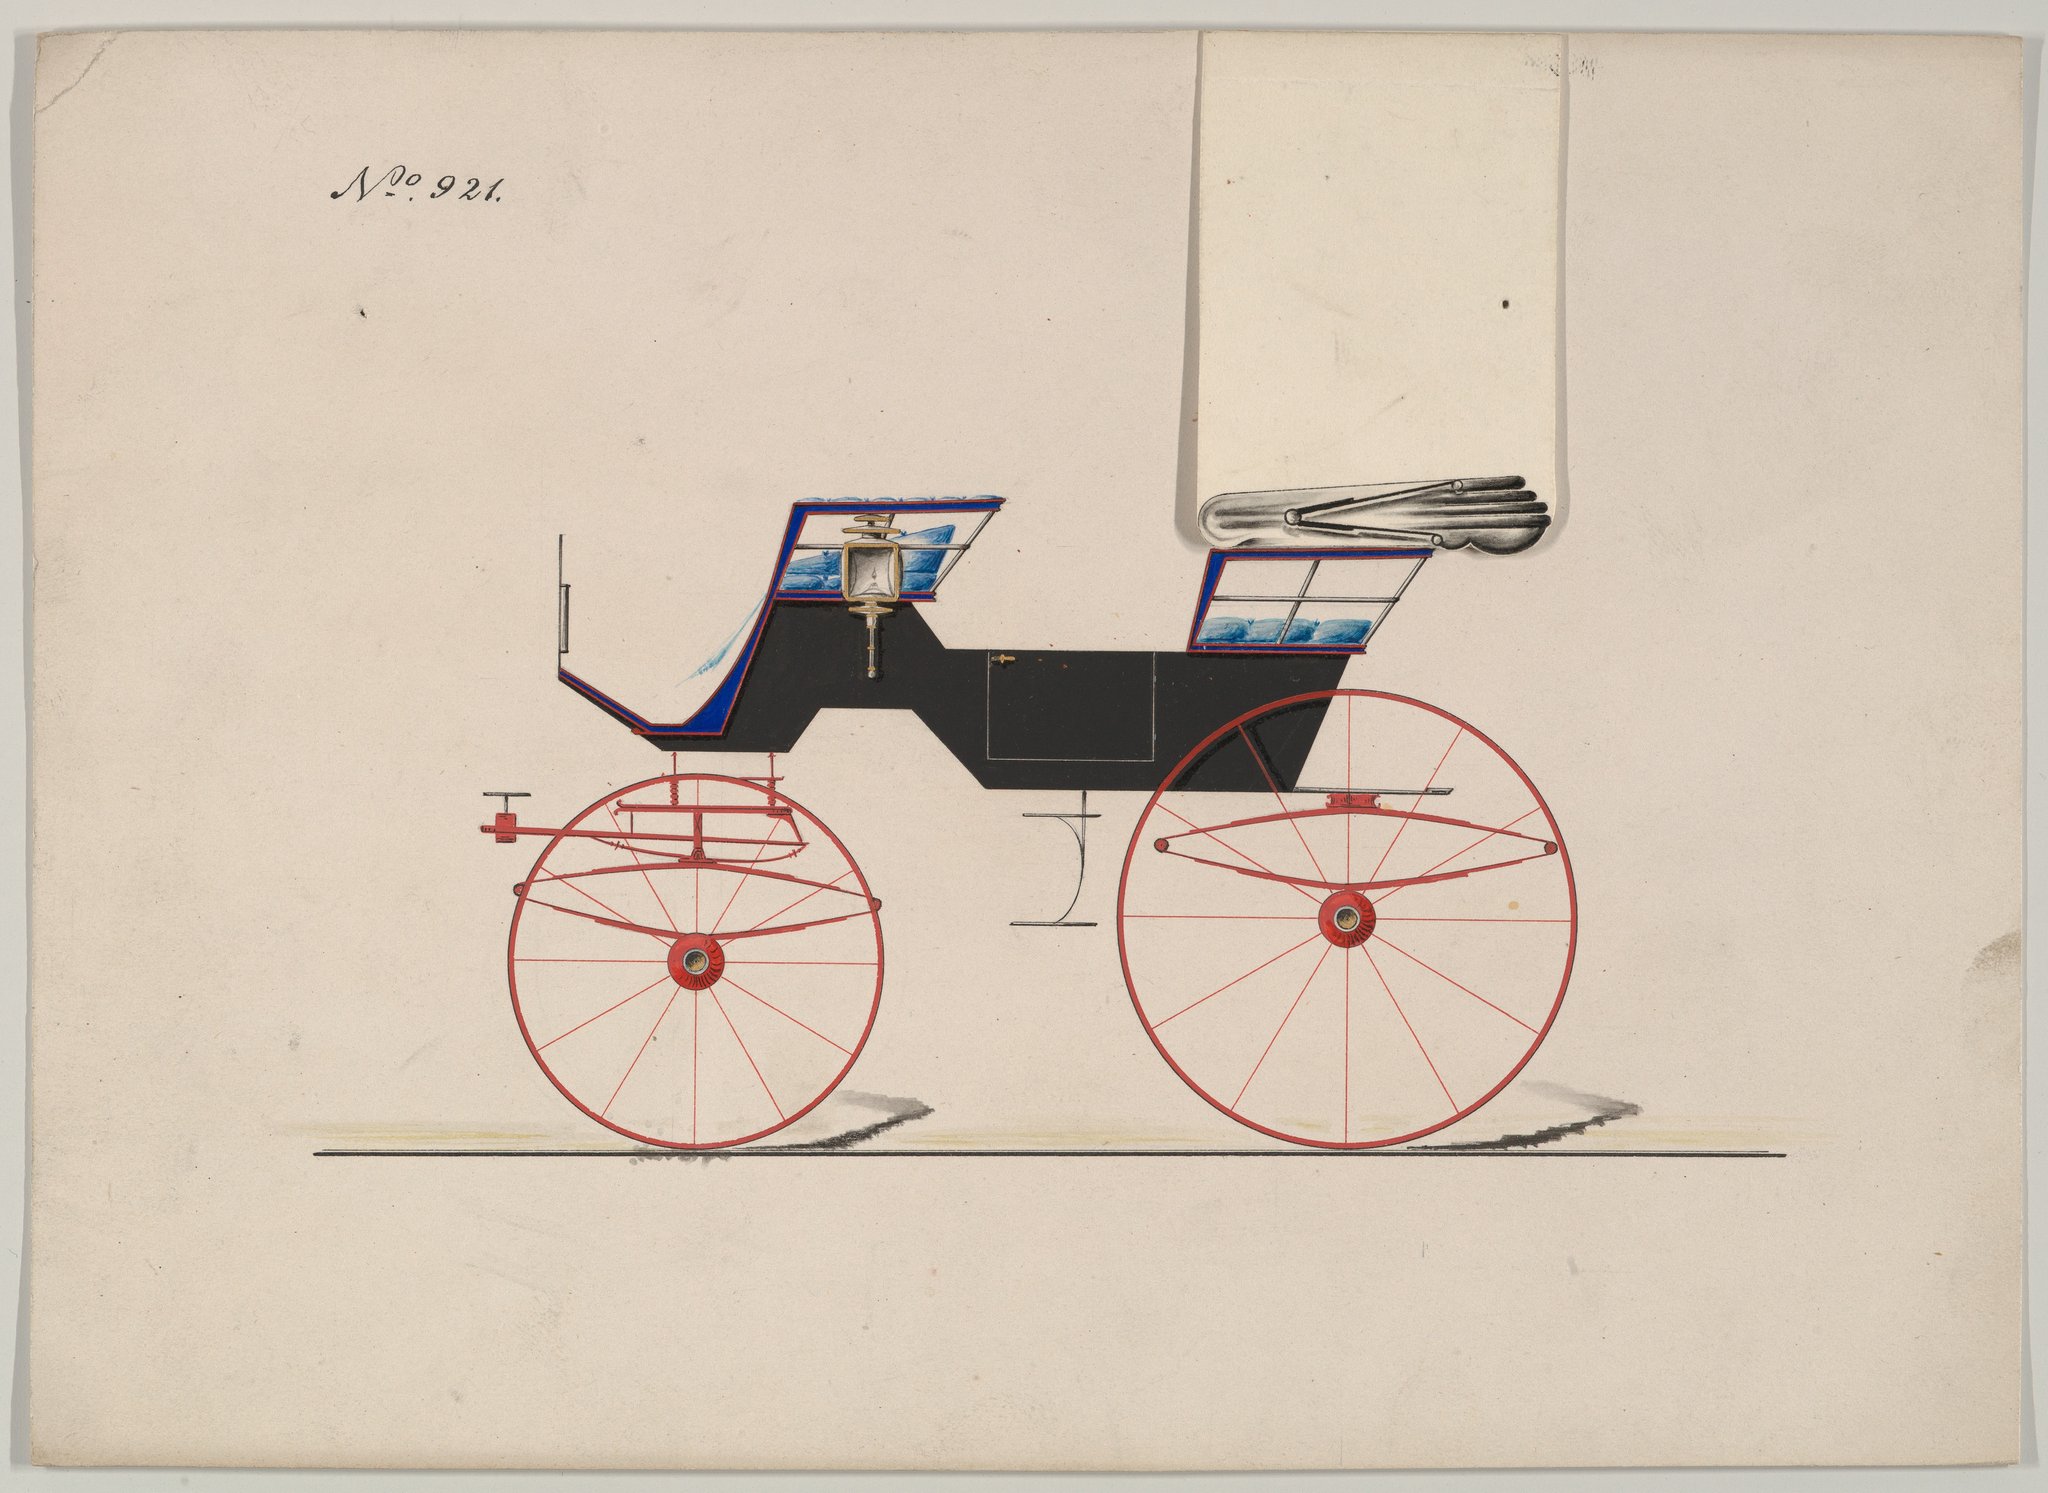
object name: drawing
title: Design for Phaeton, no. 921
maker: brewster & co.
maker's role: manufacturer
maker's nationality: american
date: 1850-1874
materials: gouache, gum arabic, ink, watercolor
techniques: pen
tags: carriages